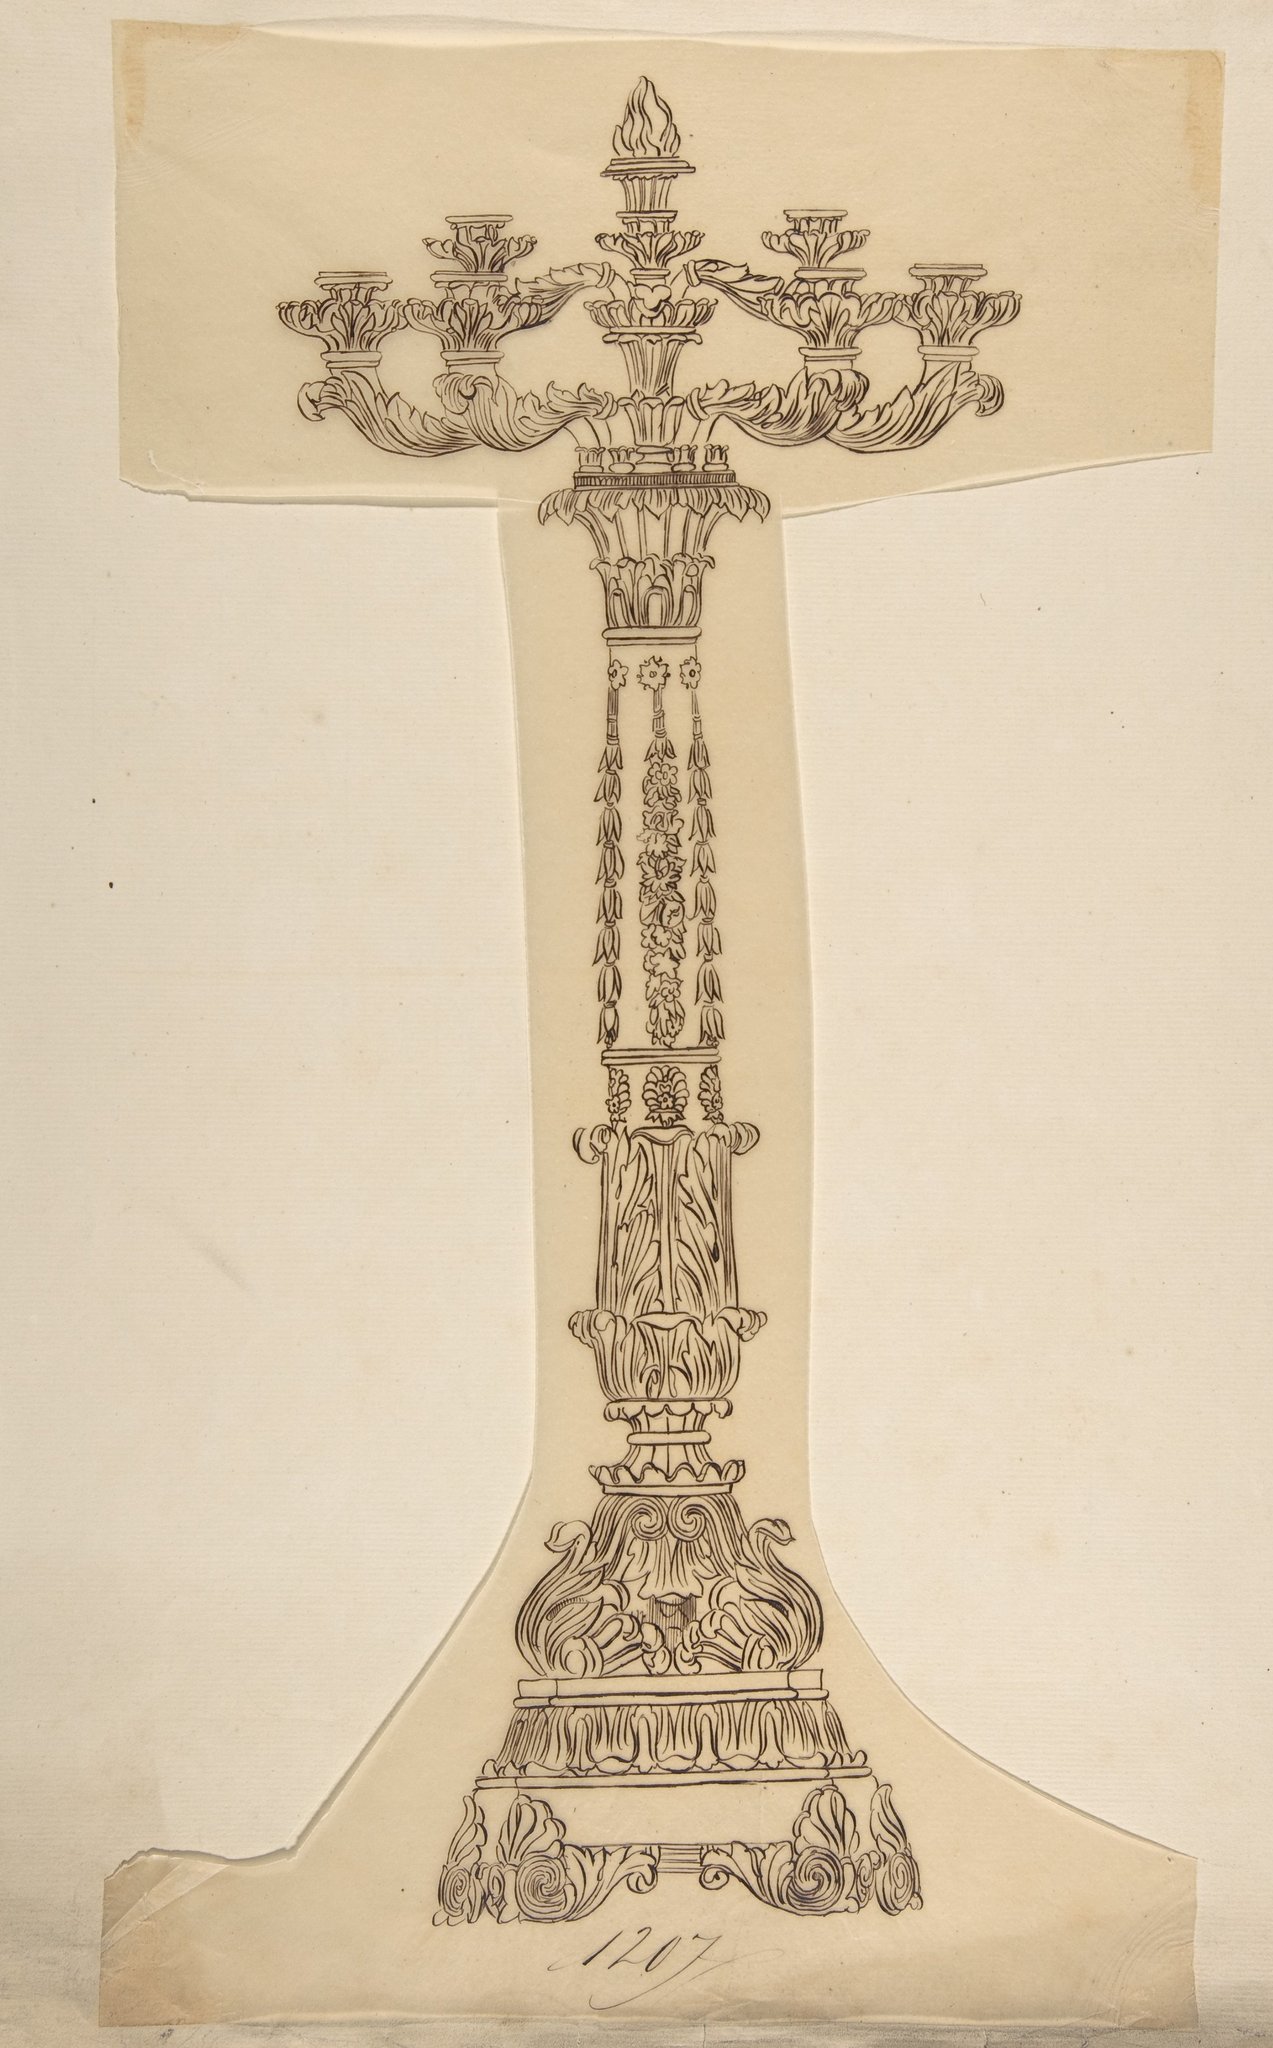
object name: drawing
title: Design for a Six Arm Candelabra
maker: anonymous, french, 19th century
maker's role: artist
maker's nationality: french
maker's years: 1800-1900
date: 1801-1900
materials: ink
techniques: pen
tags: candelabra